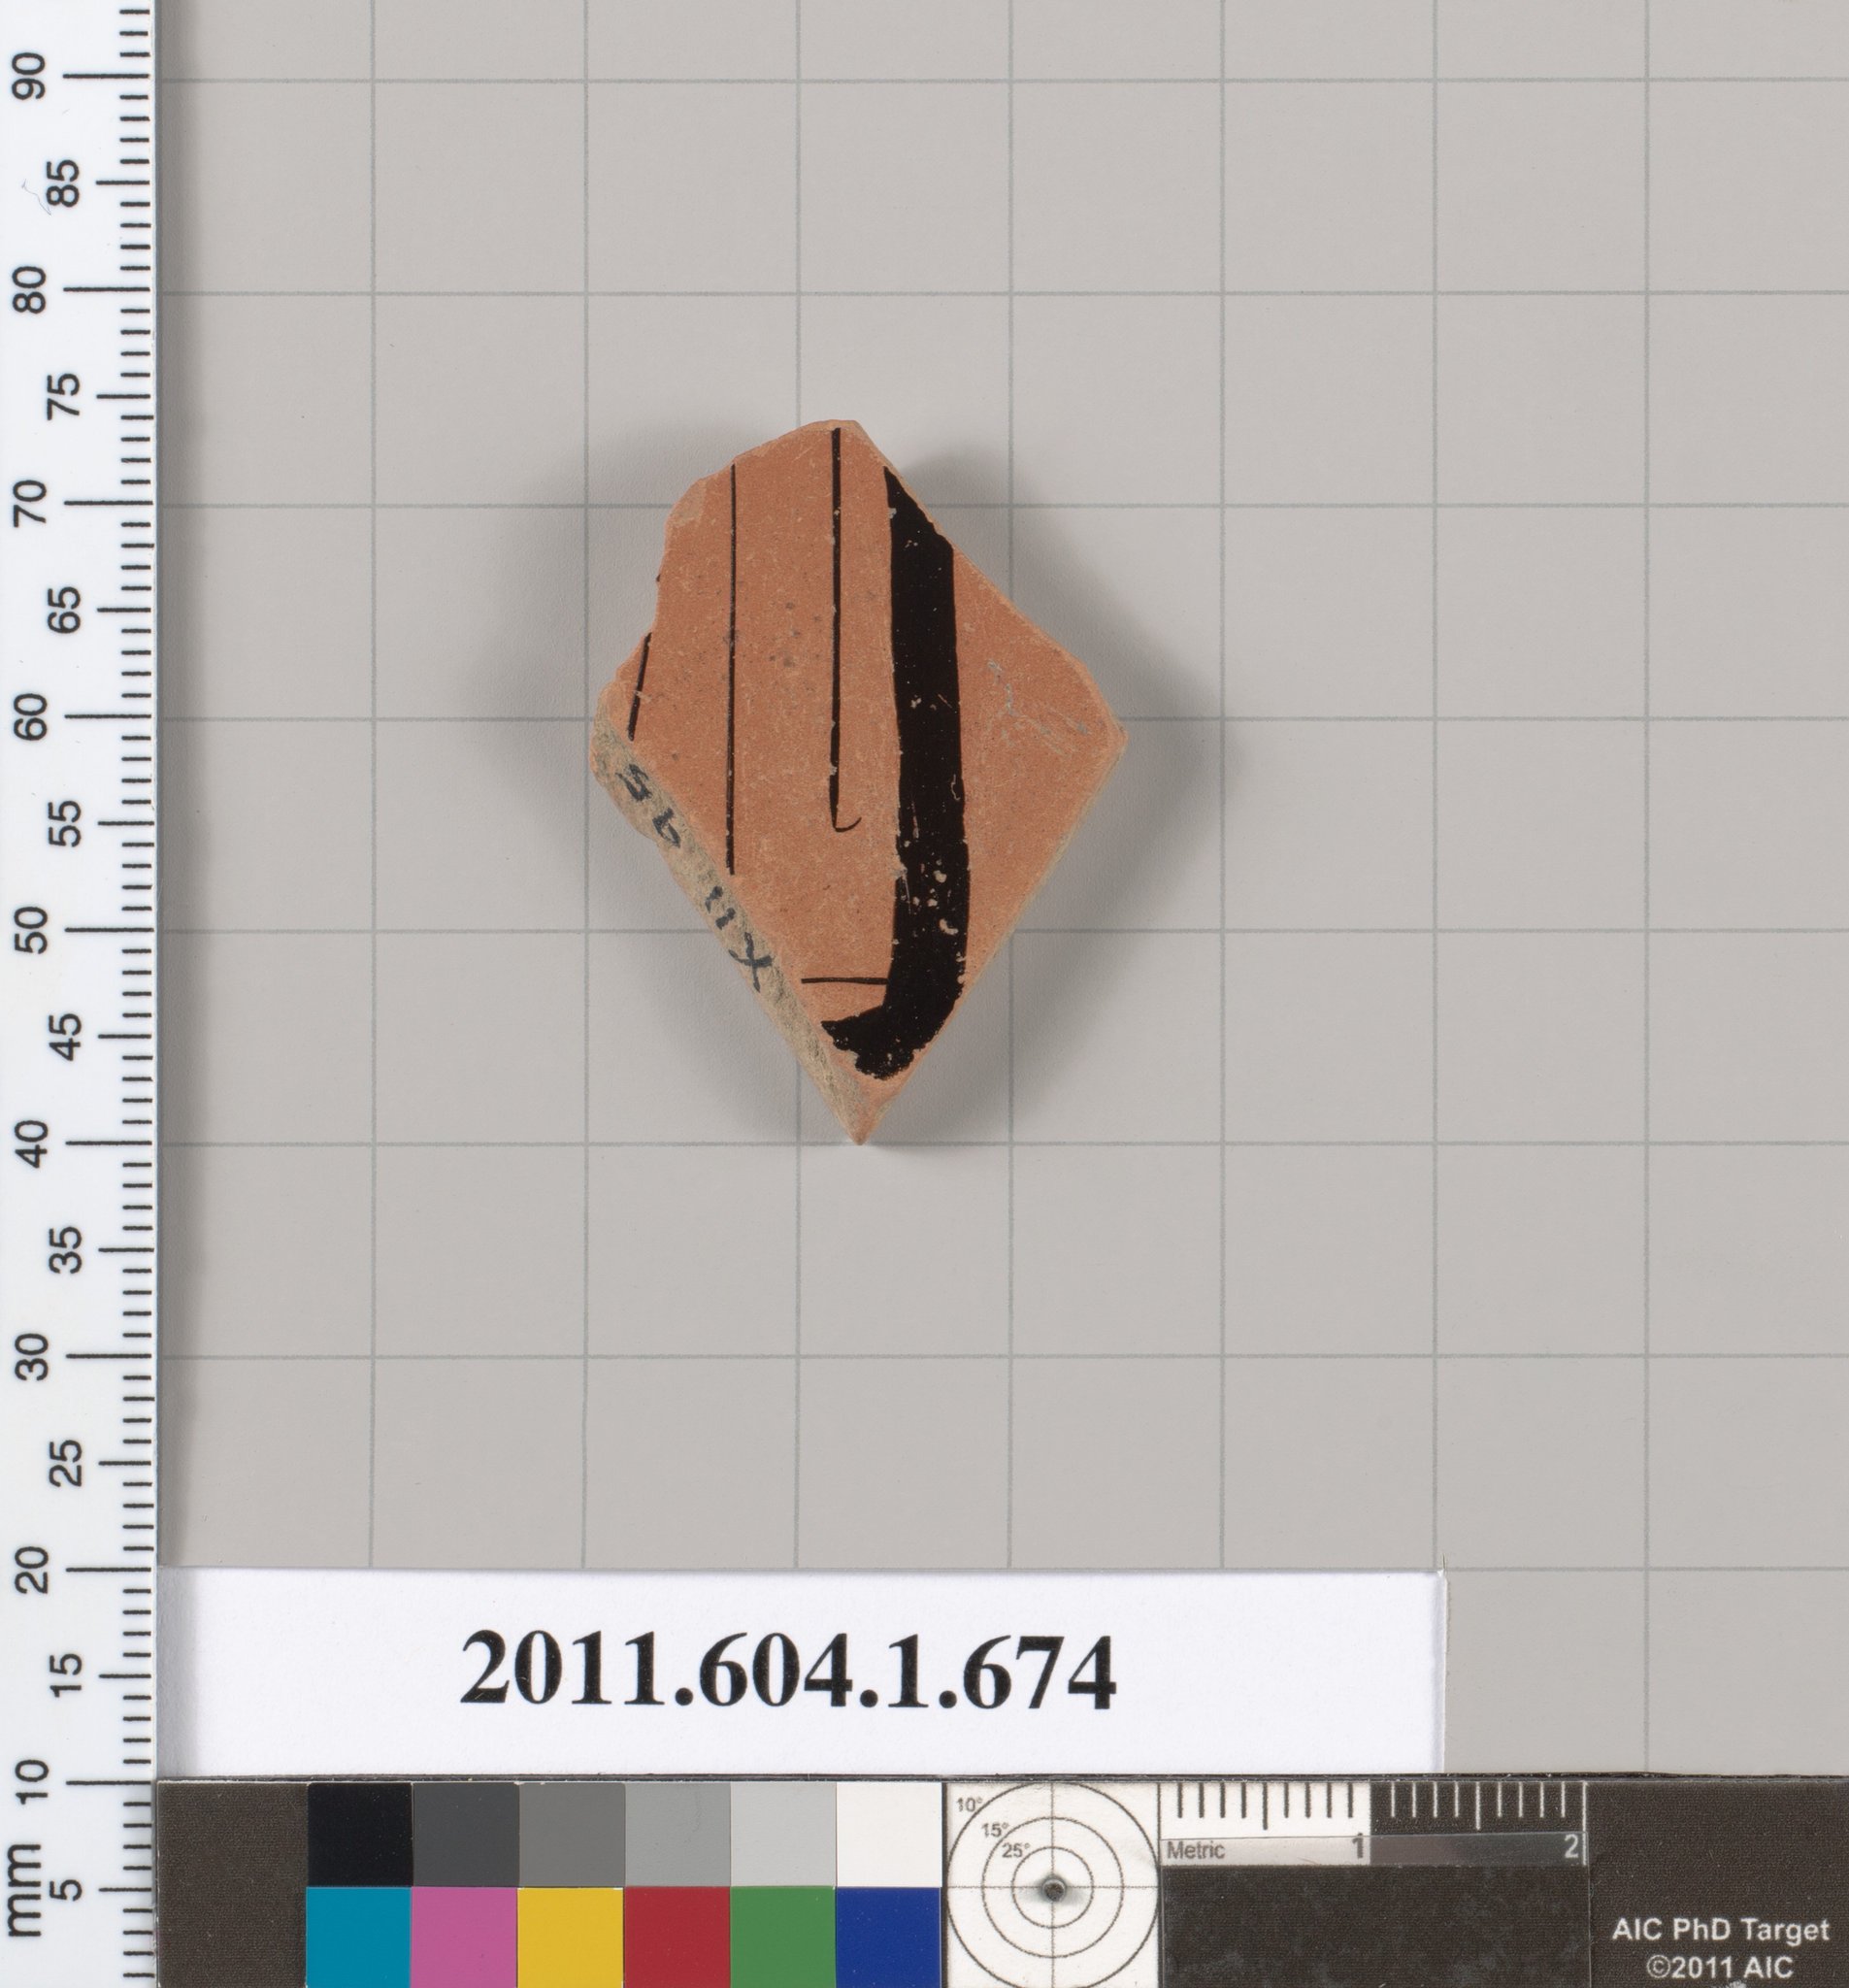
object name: kylix fragment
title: Terracotta fragment of a kylix (drinking cup)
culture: greek, attic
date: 500-401 BCE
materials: terracotta